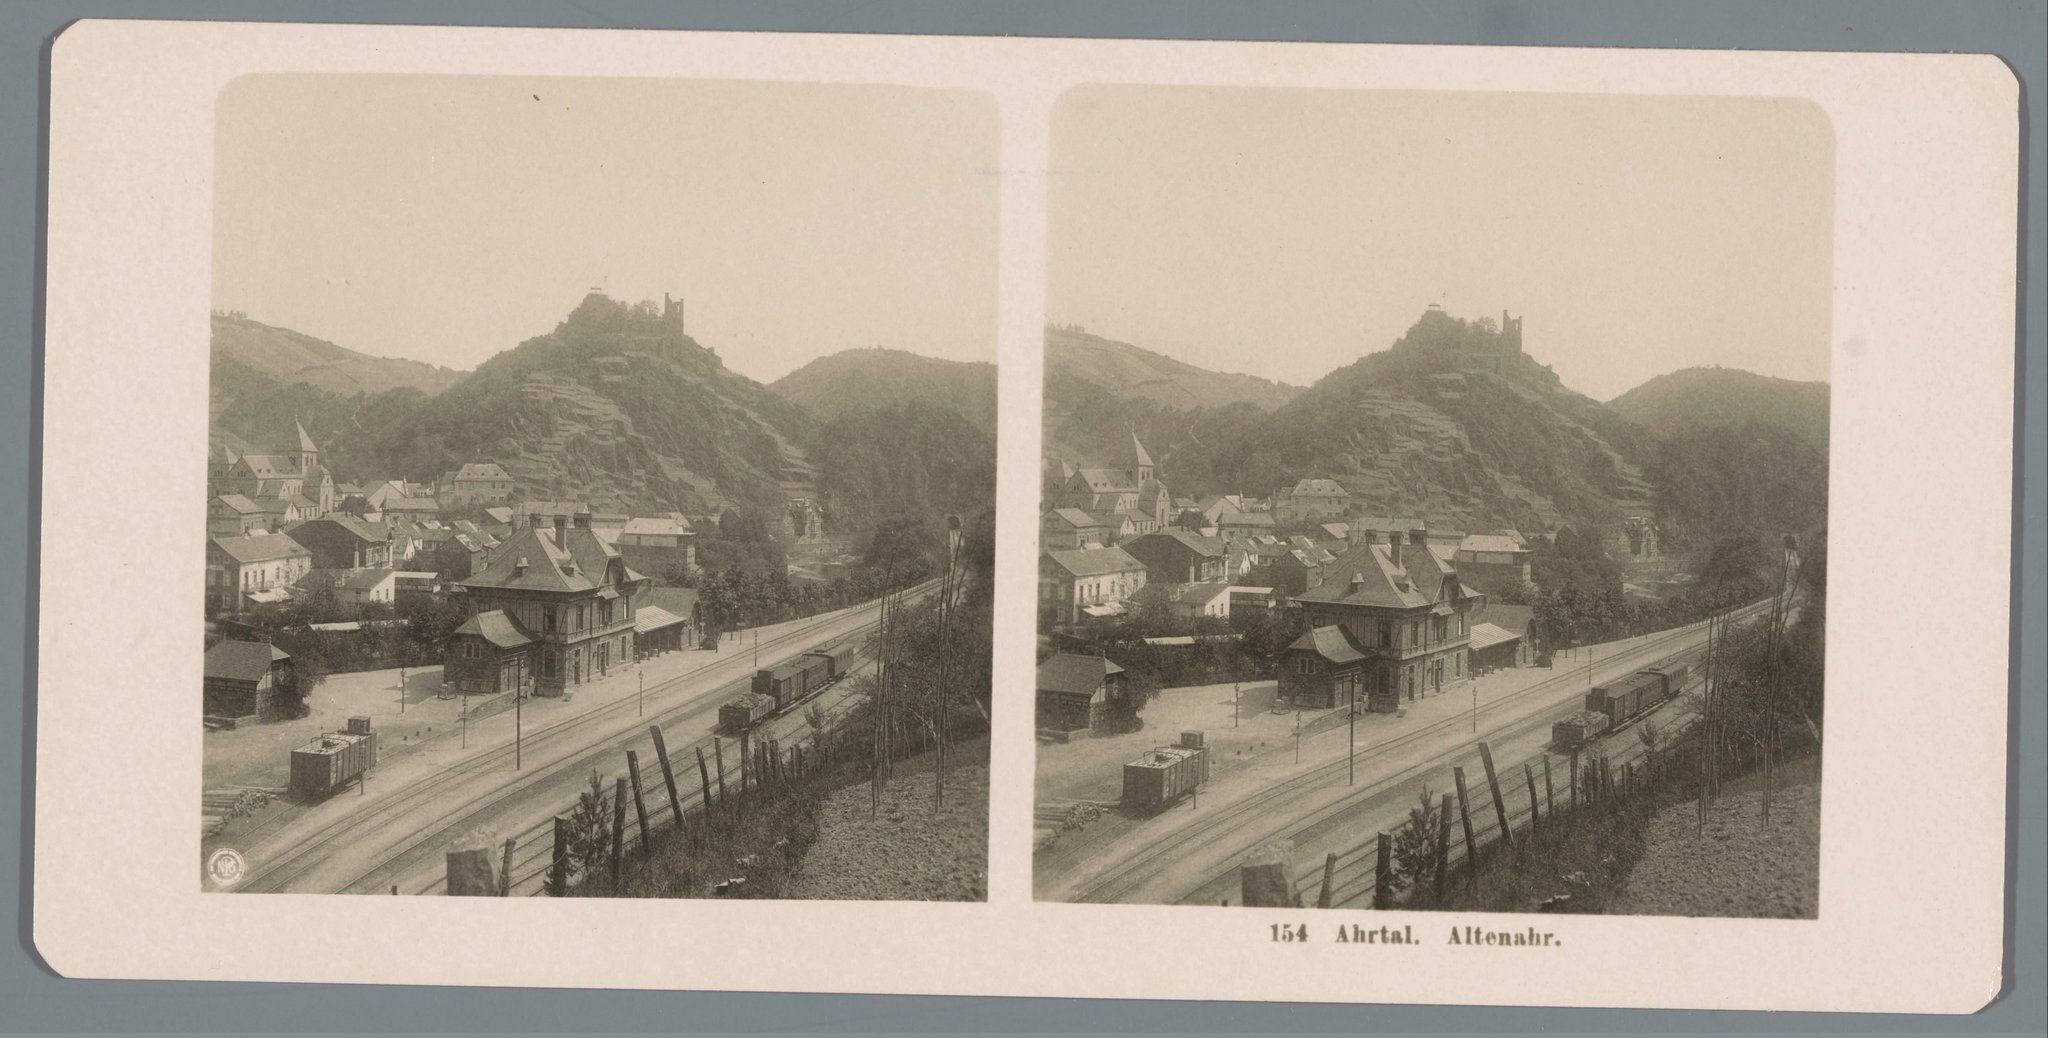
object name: stereograph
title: Ahrtal. Altenahr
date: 1900-1910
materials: cardboard, photographic support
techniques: gelatin silver print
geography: rhineland-palatinate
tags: city-view in general; 'veduta'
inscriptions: inscription: ‘NPG’, number: ‘154’